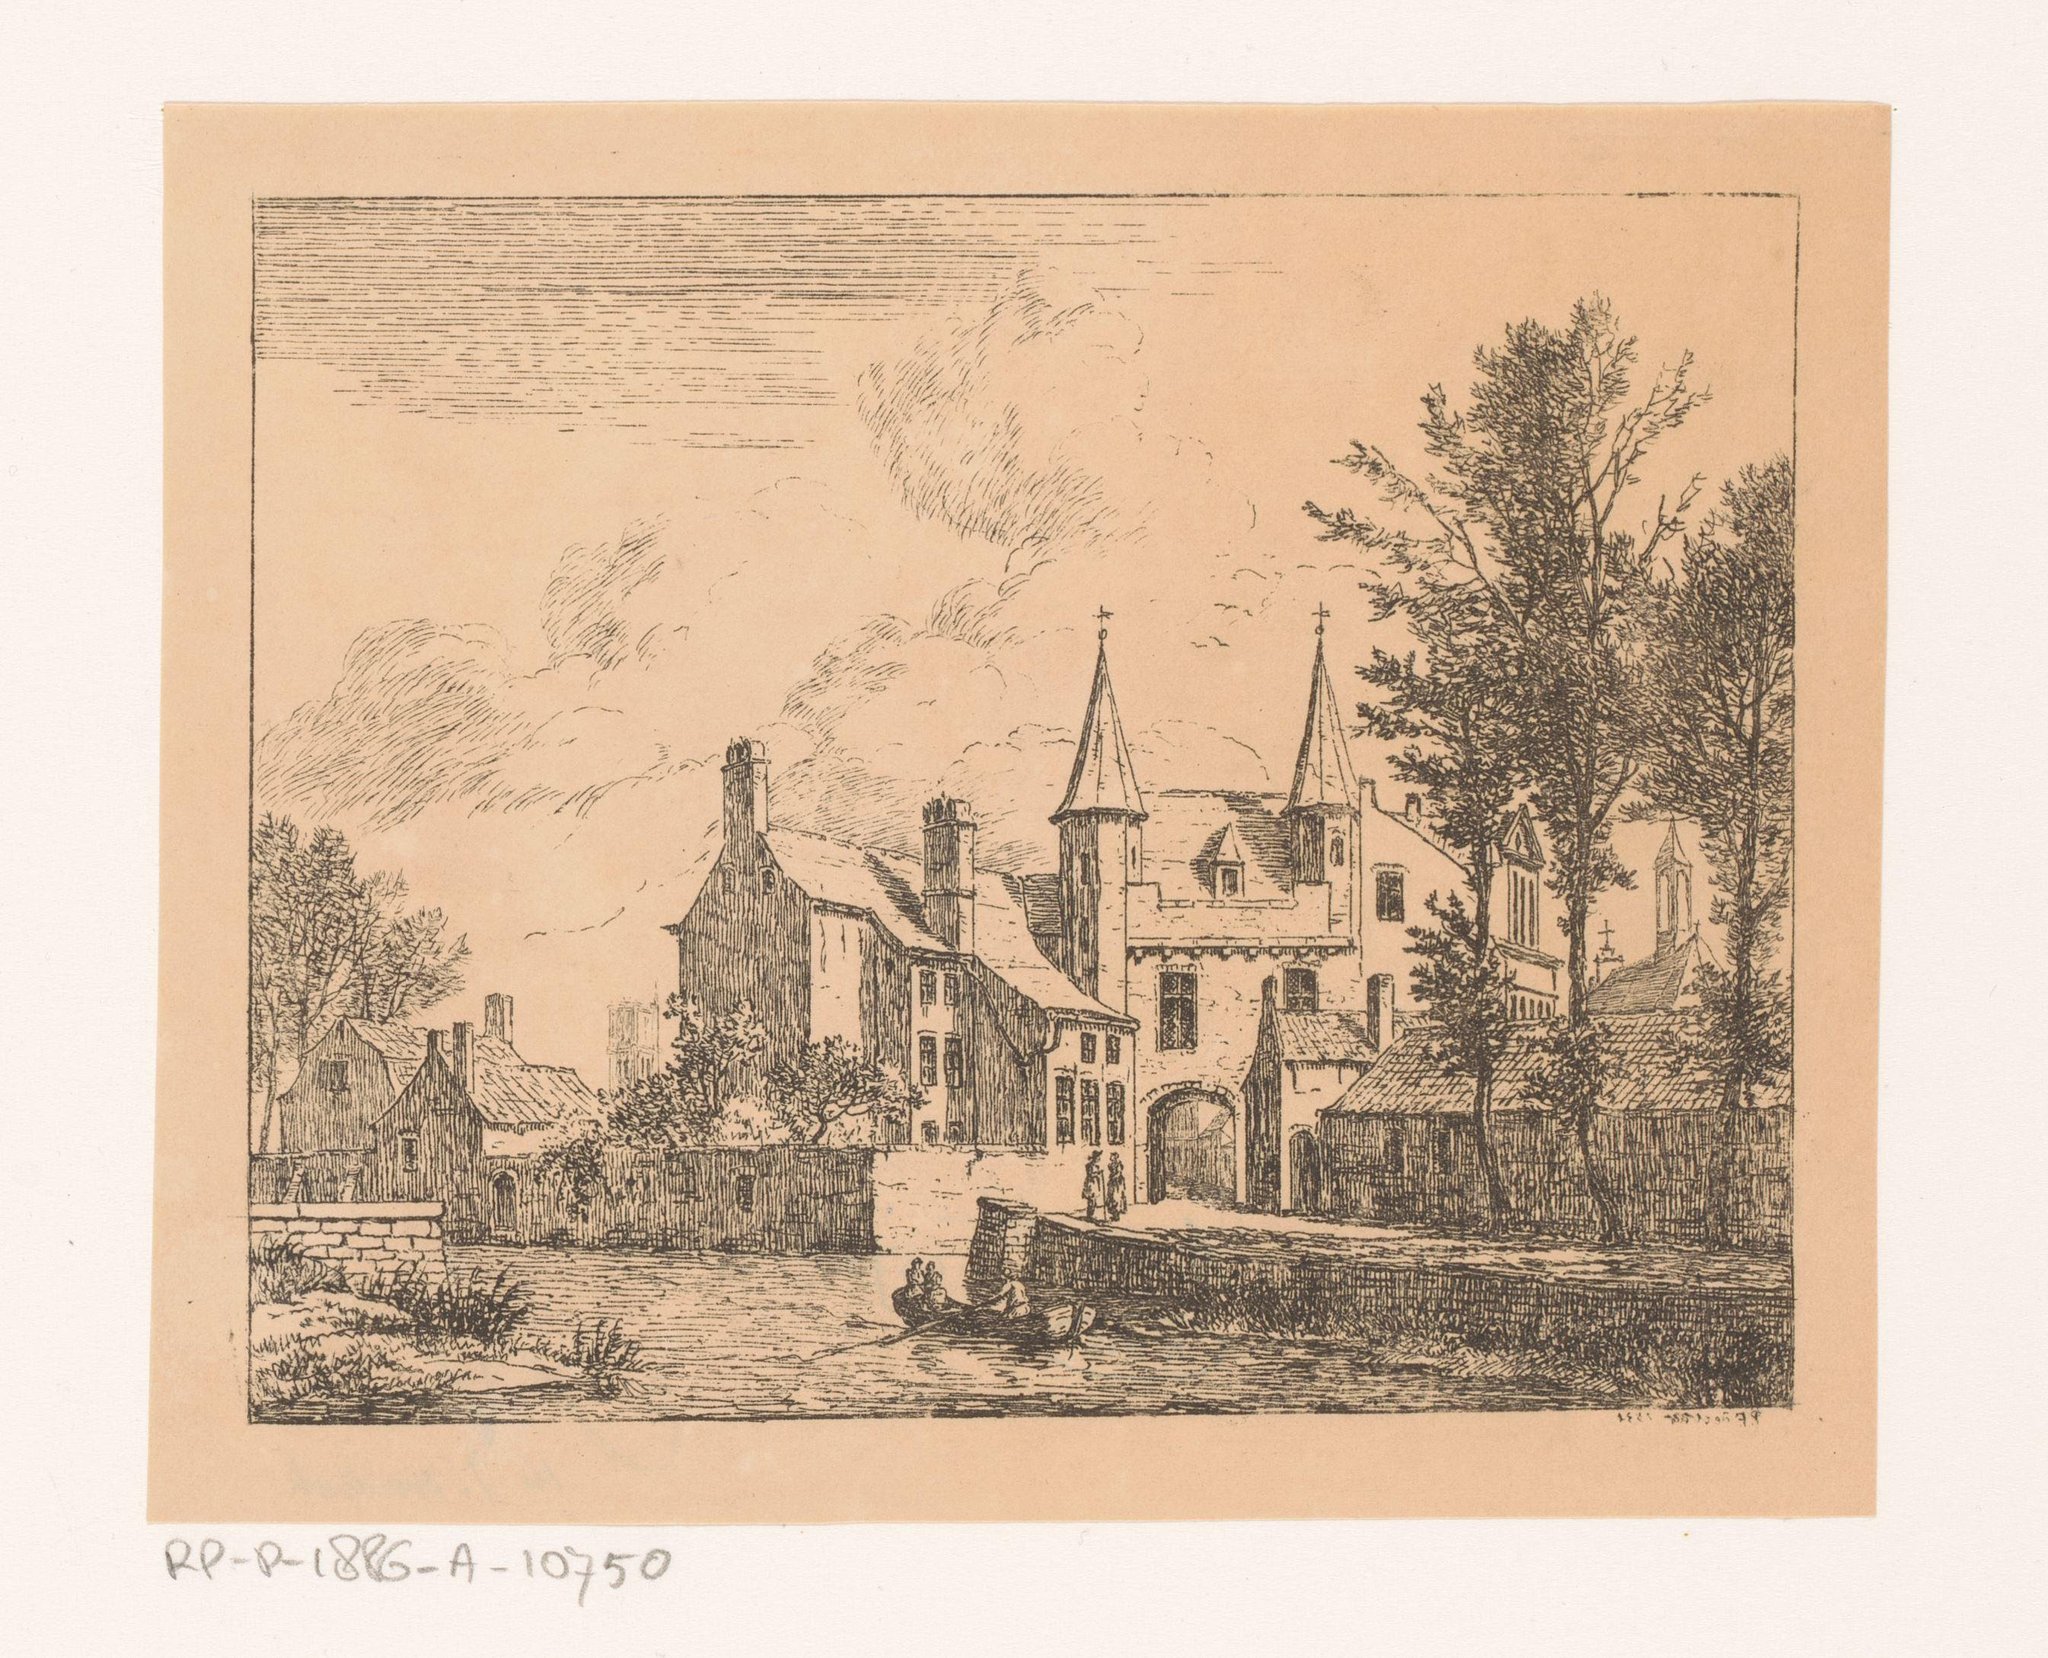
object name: print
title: Gezicht op het Prinsenhof te Gent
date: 1831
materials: paper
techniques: printmaking, etching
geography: ghent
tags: city-gate, canals, waters (in city) (+ city(-scape) with figures, staffage), ghent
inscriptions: collector's mark: Lugt 2228